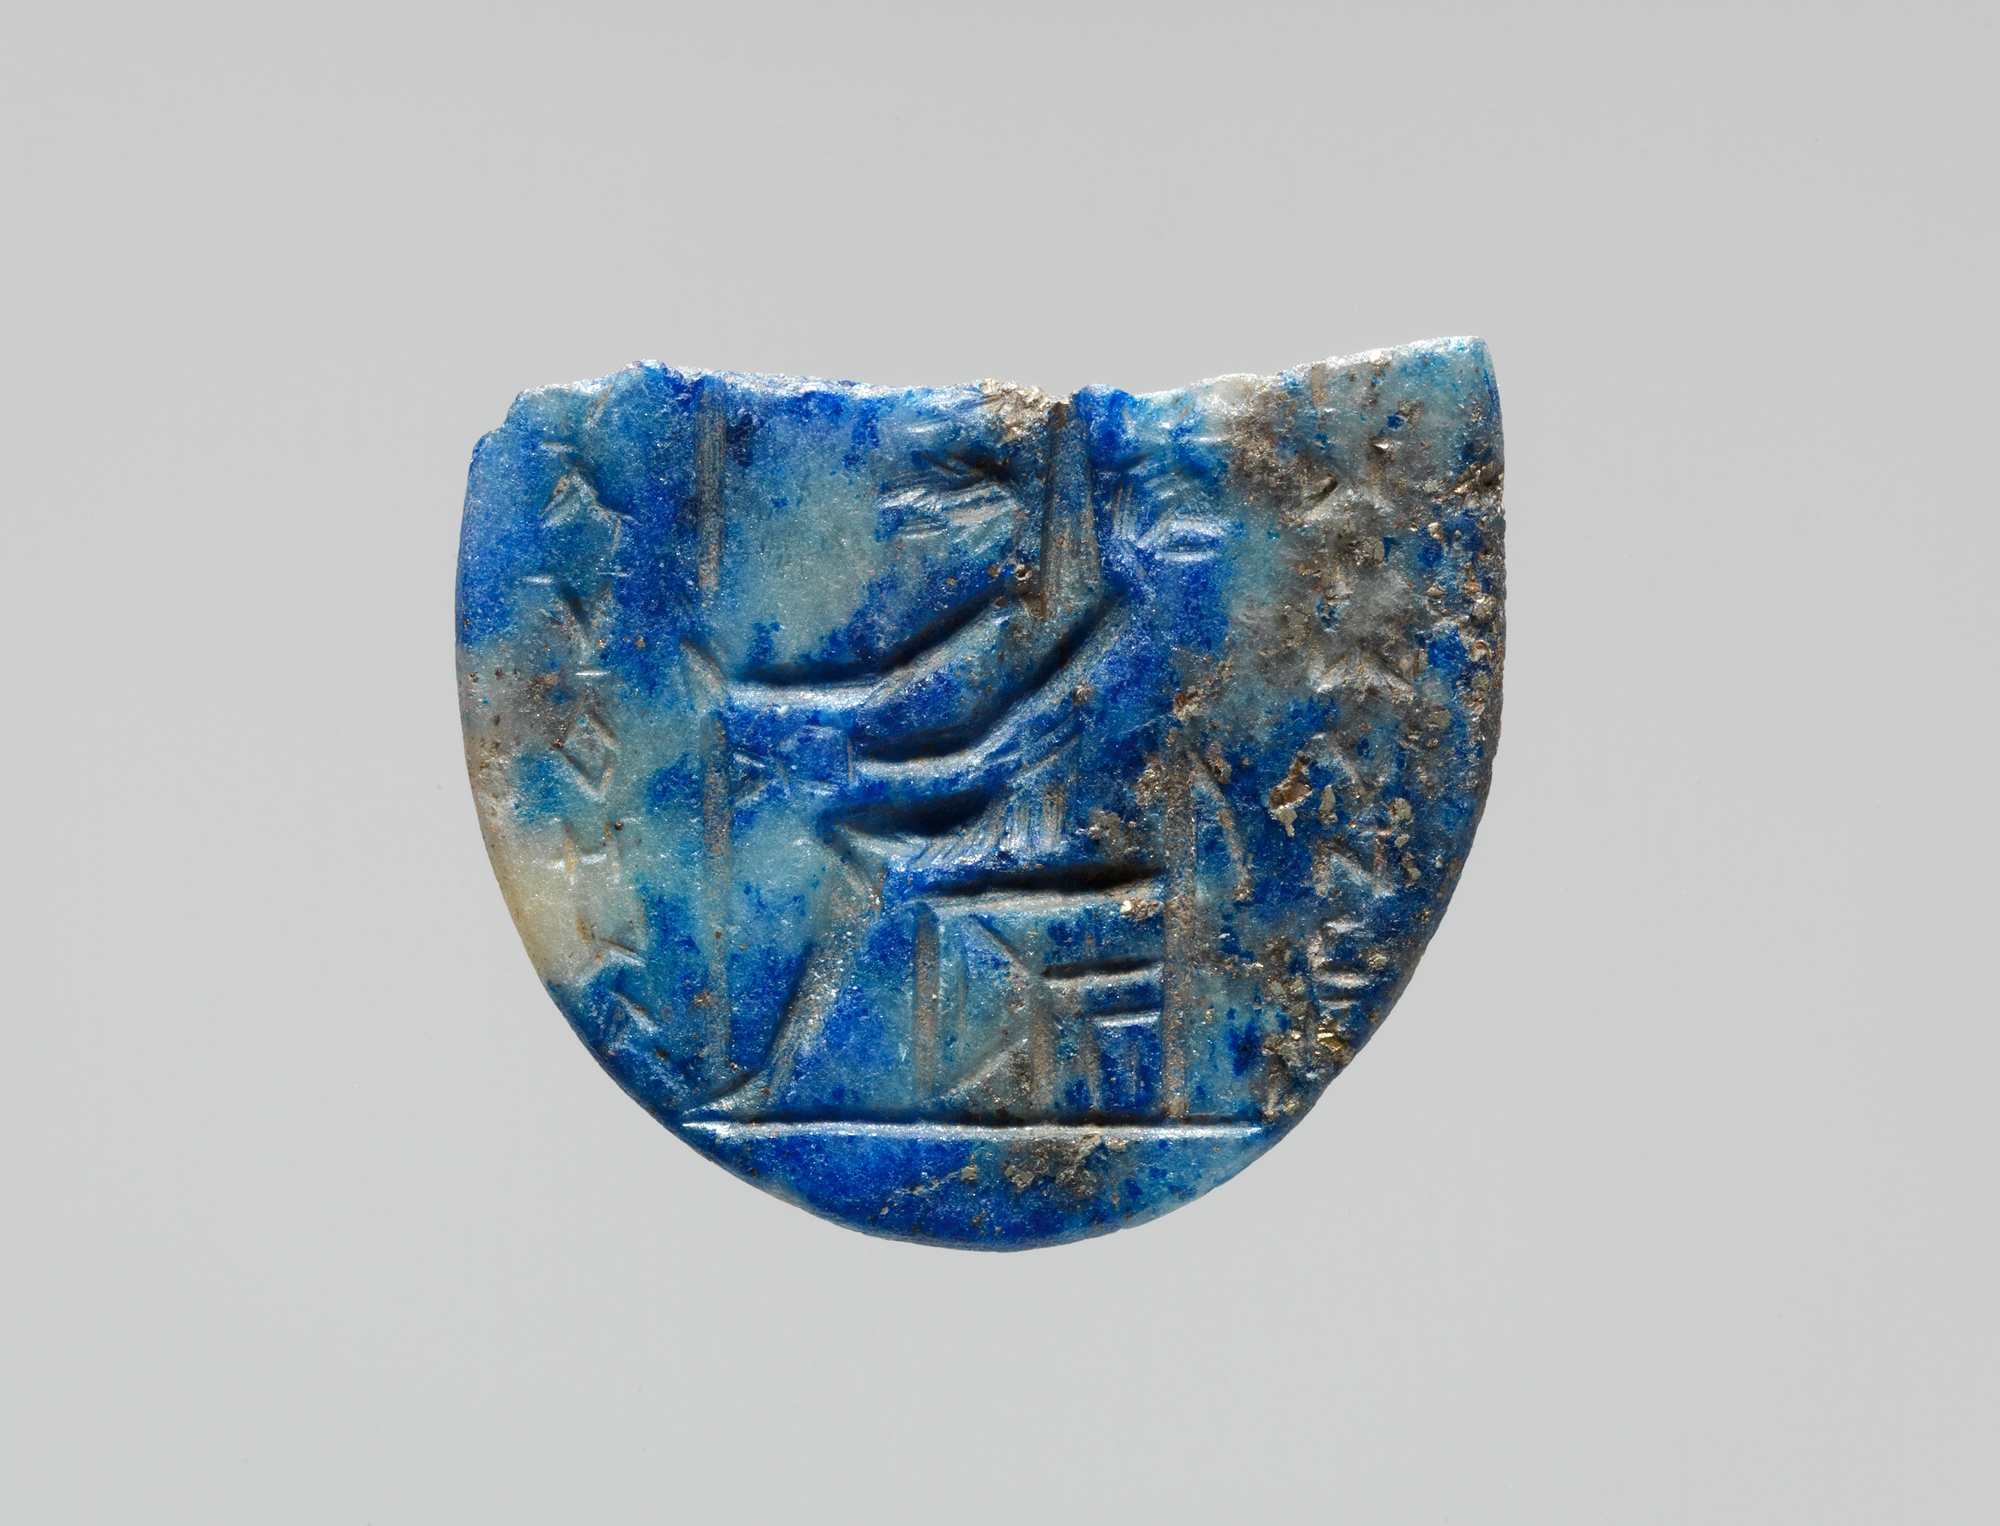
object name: intaglio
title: Lapis lazuli intaglio: Seated deity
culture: roman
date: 101-200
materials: lapis lazuli